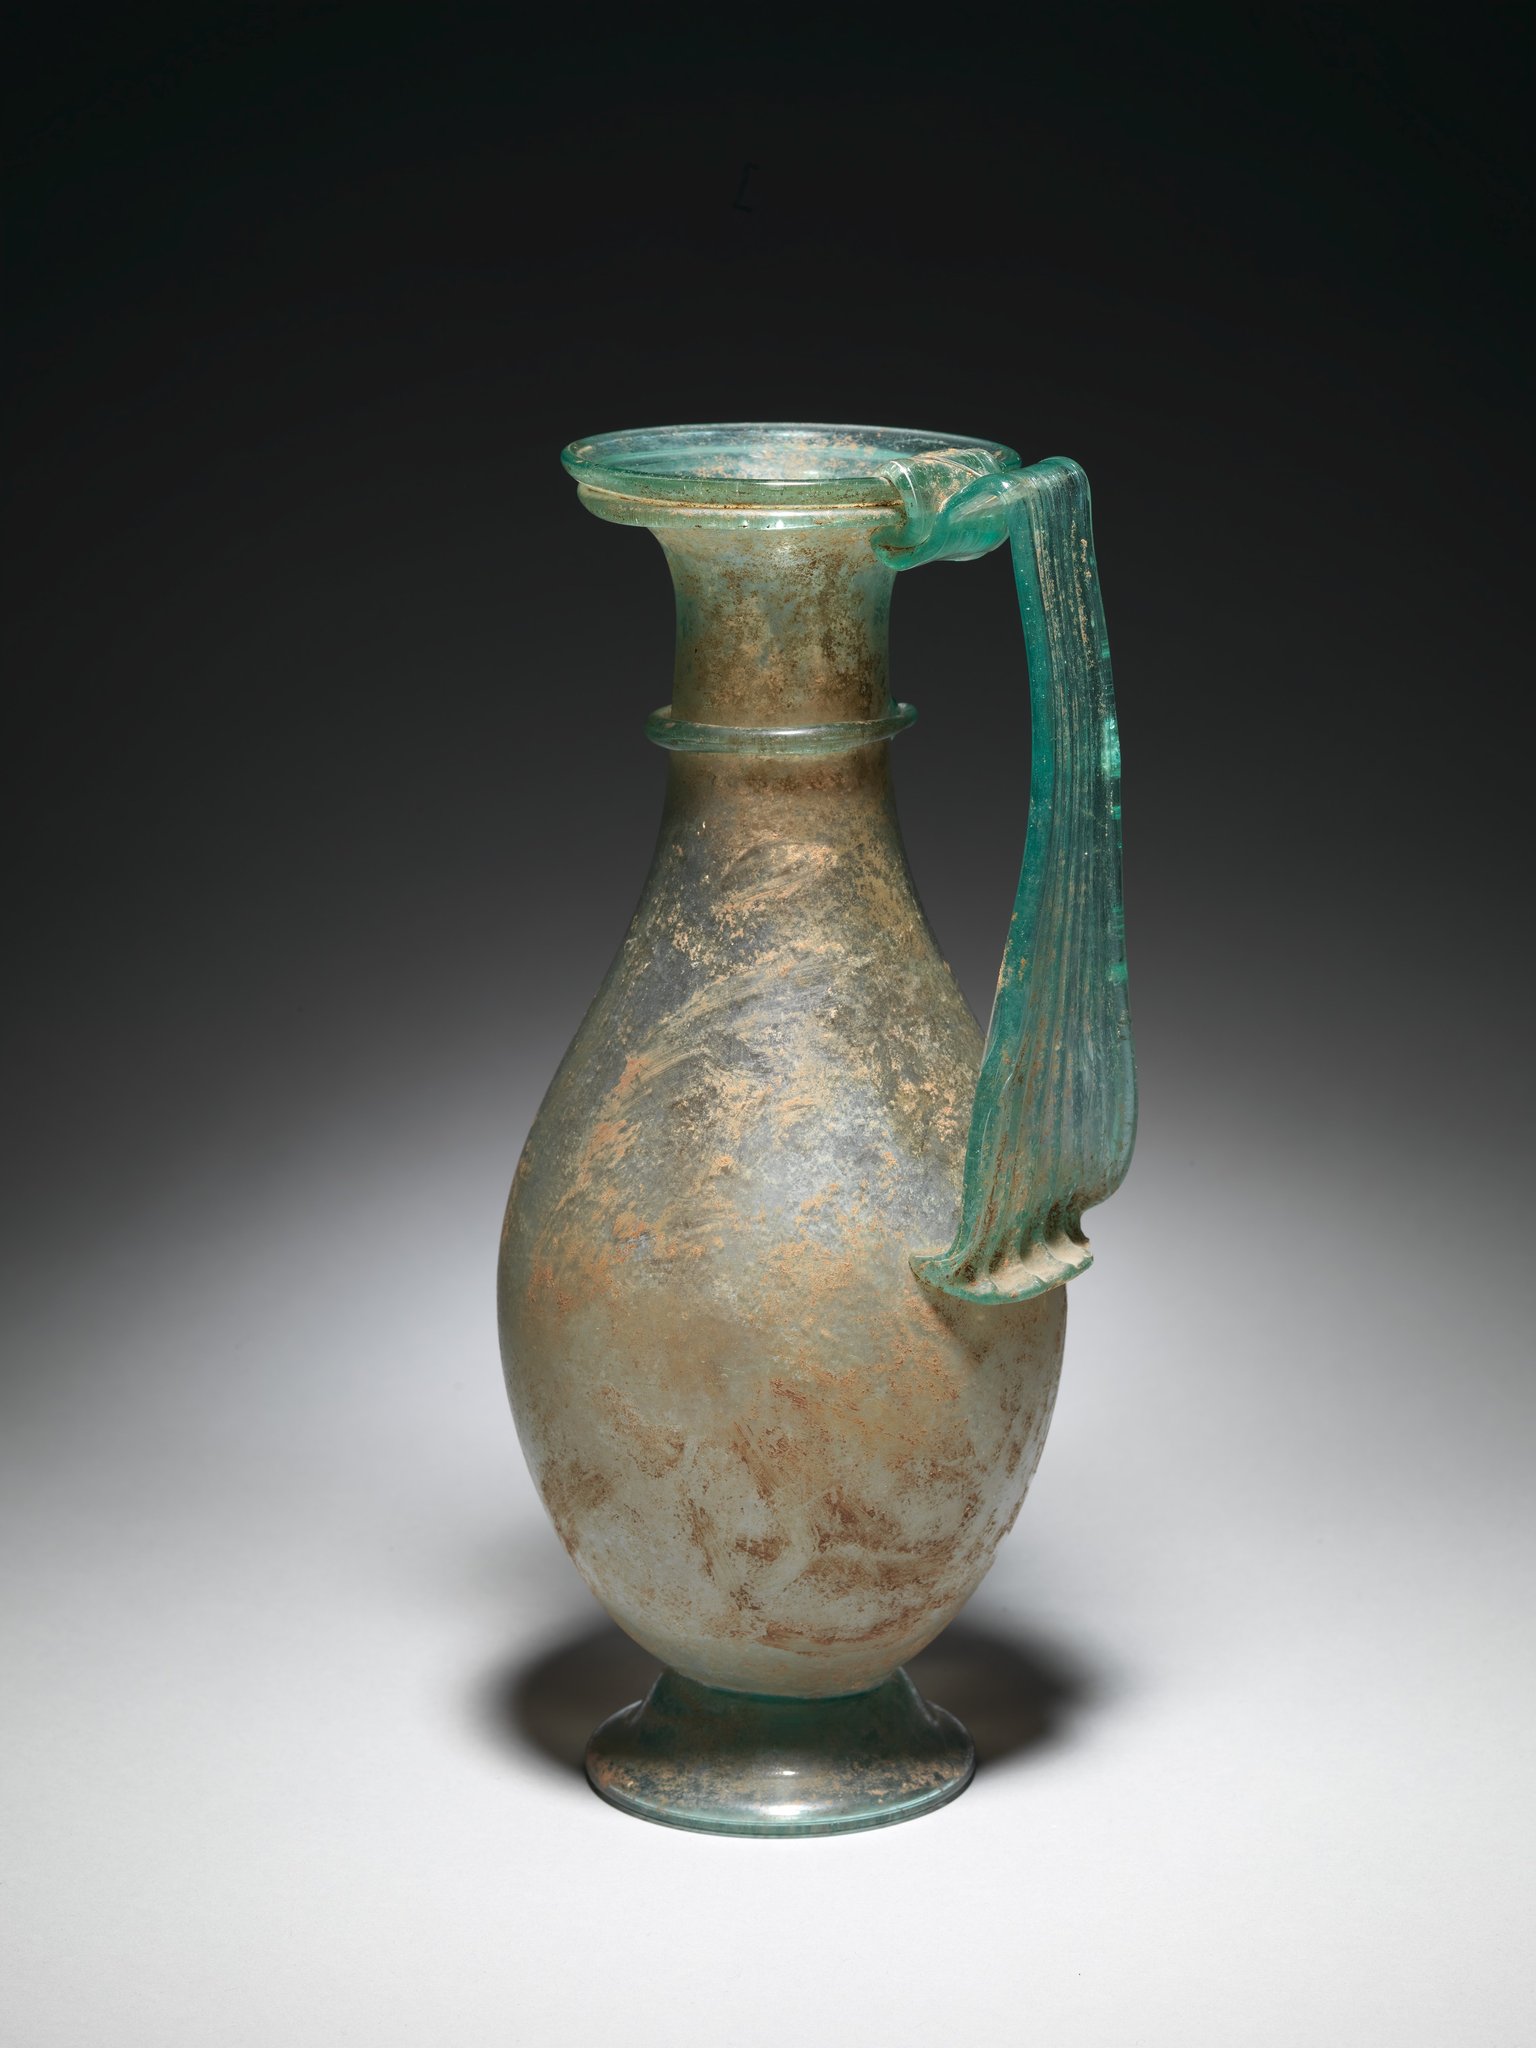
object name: jug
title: Glass jug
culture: roman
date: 301-400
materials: glass